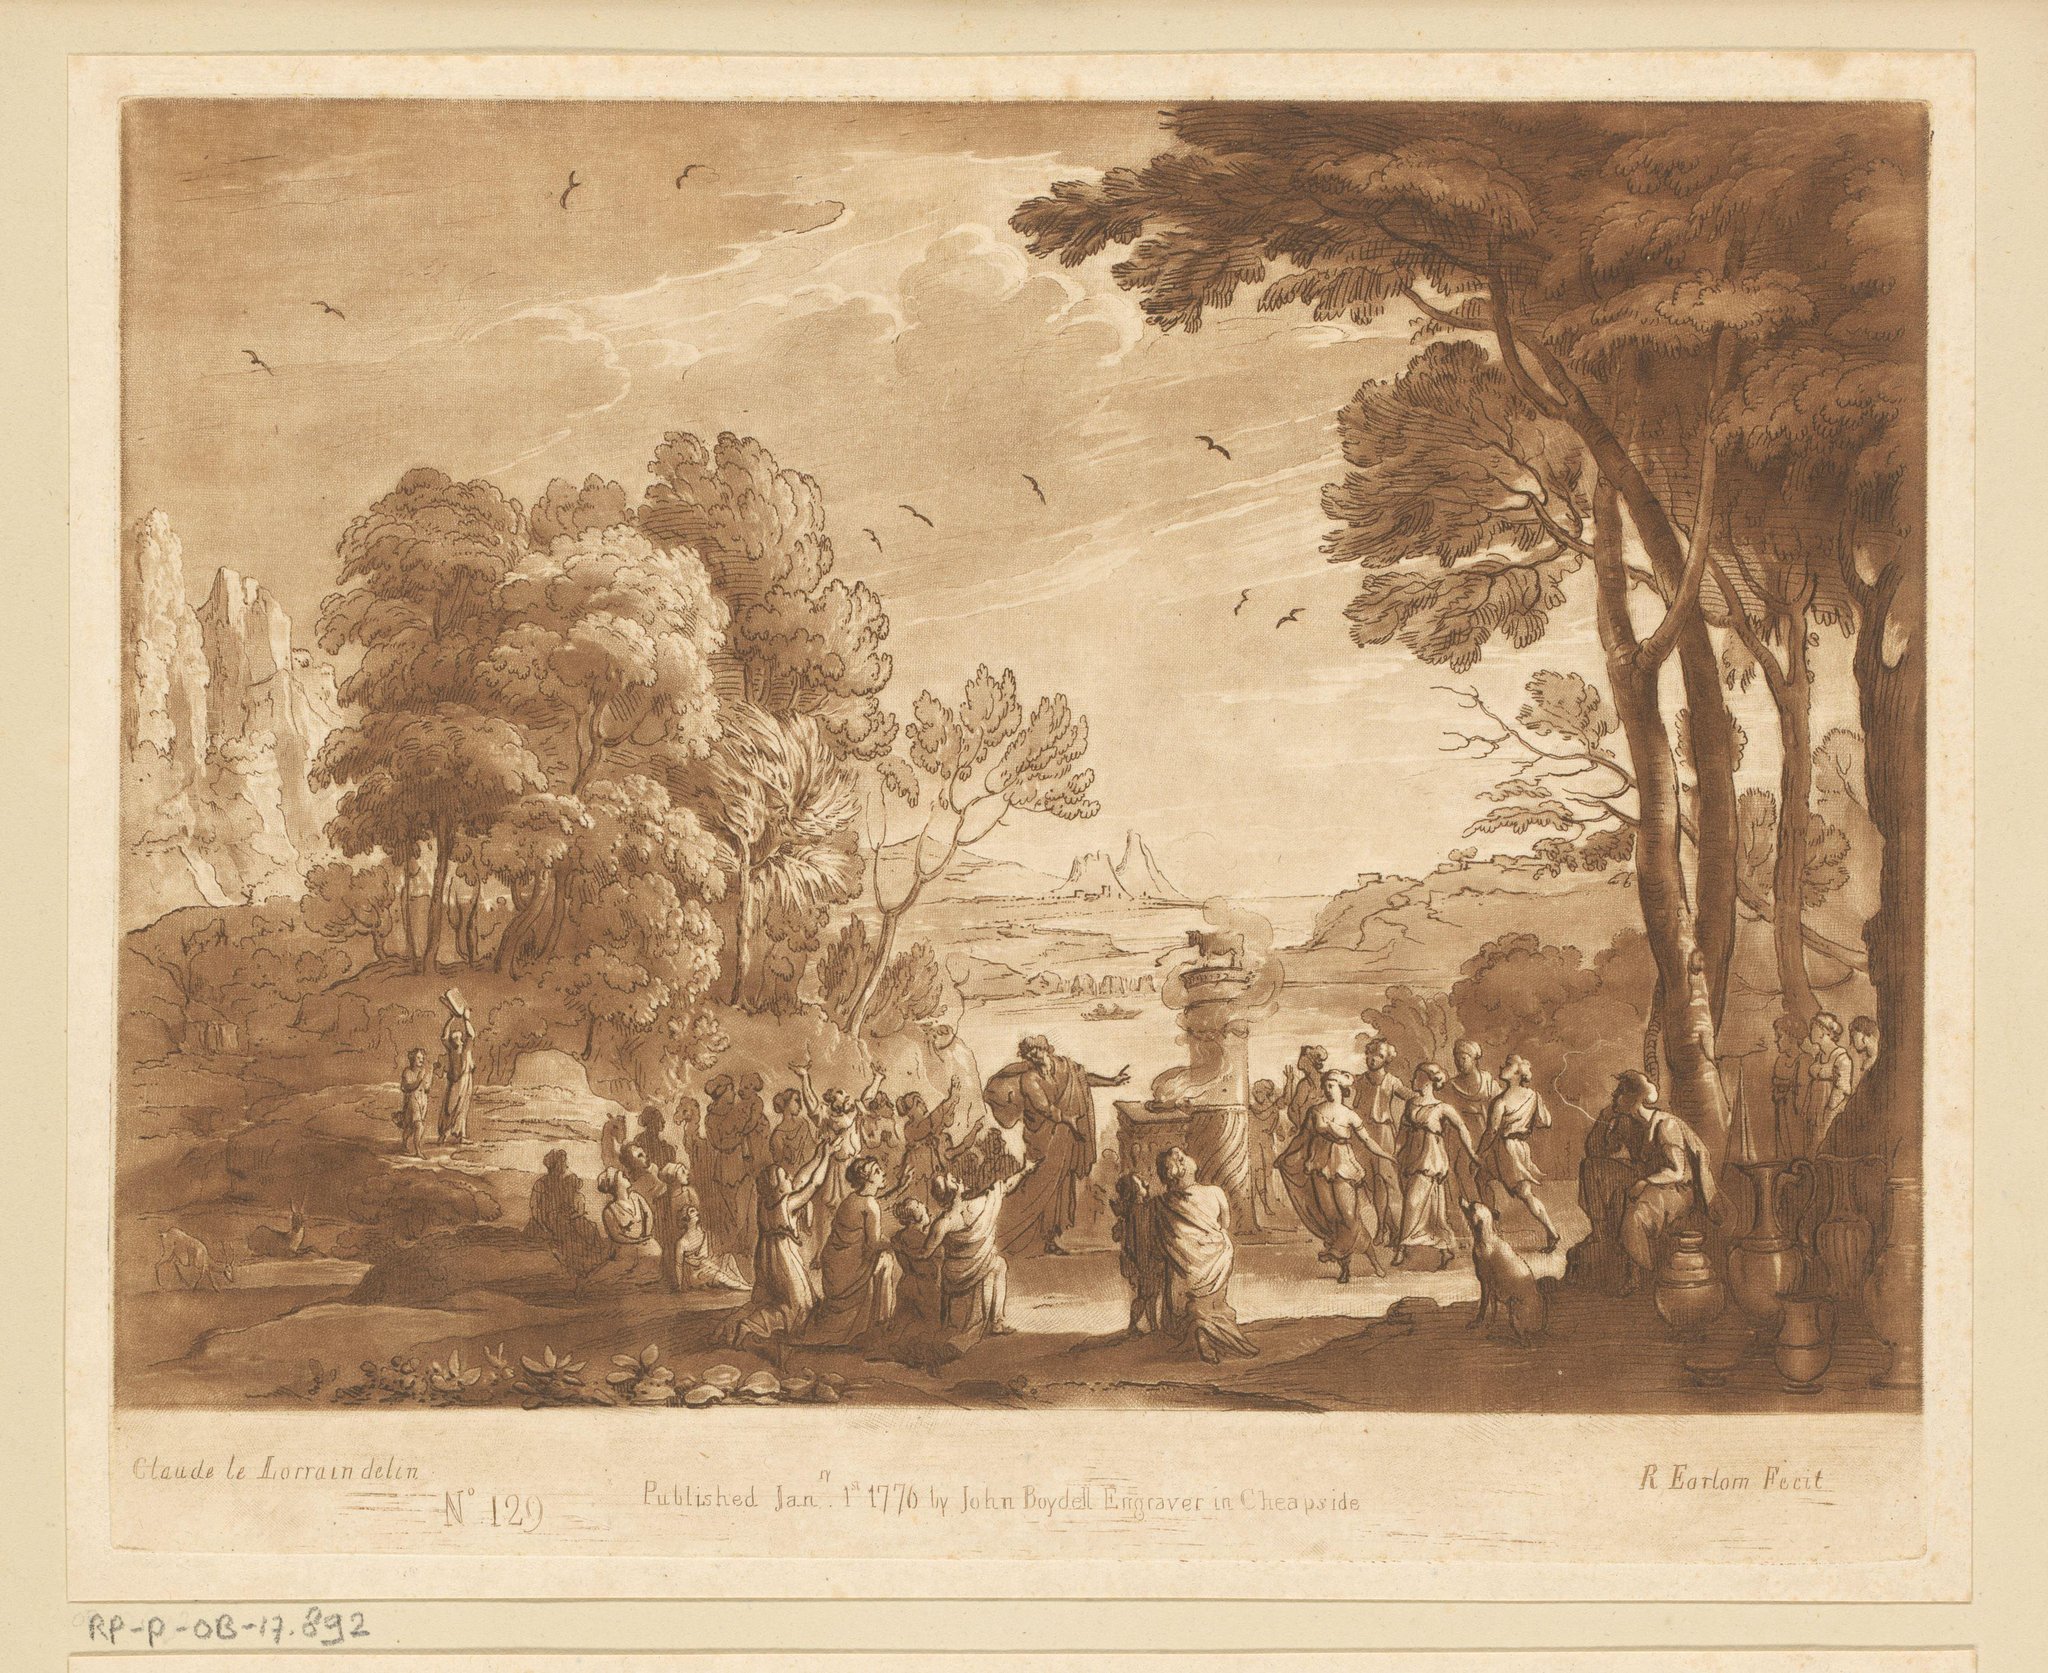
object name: print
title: Prenten naar tekeningen van Claude Lorrain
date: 1776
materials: paper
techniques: etching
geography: london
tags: aaron builds an altar and offers a sacrifice to the golden calf, on seeing the idolaters moses breaks the tables of the law, the people dance around the golden calf ~ exodus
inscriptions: date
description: Vanaf 1774 publiceerde John Boydell tweehonderd prenten naar het tekeningenboek Liber Veritatis van Claude Lorrain, in het bezit van de hertogen van Cavendish. Deze prenten werden vanaf 1777 in twee volumes gebundeld uitgegeven.